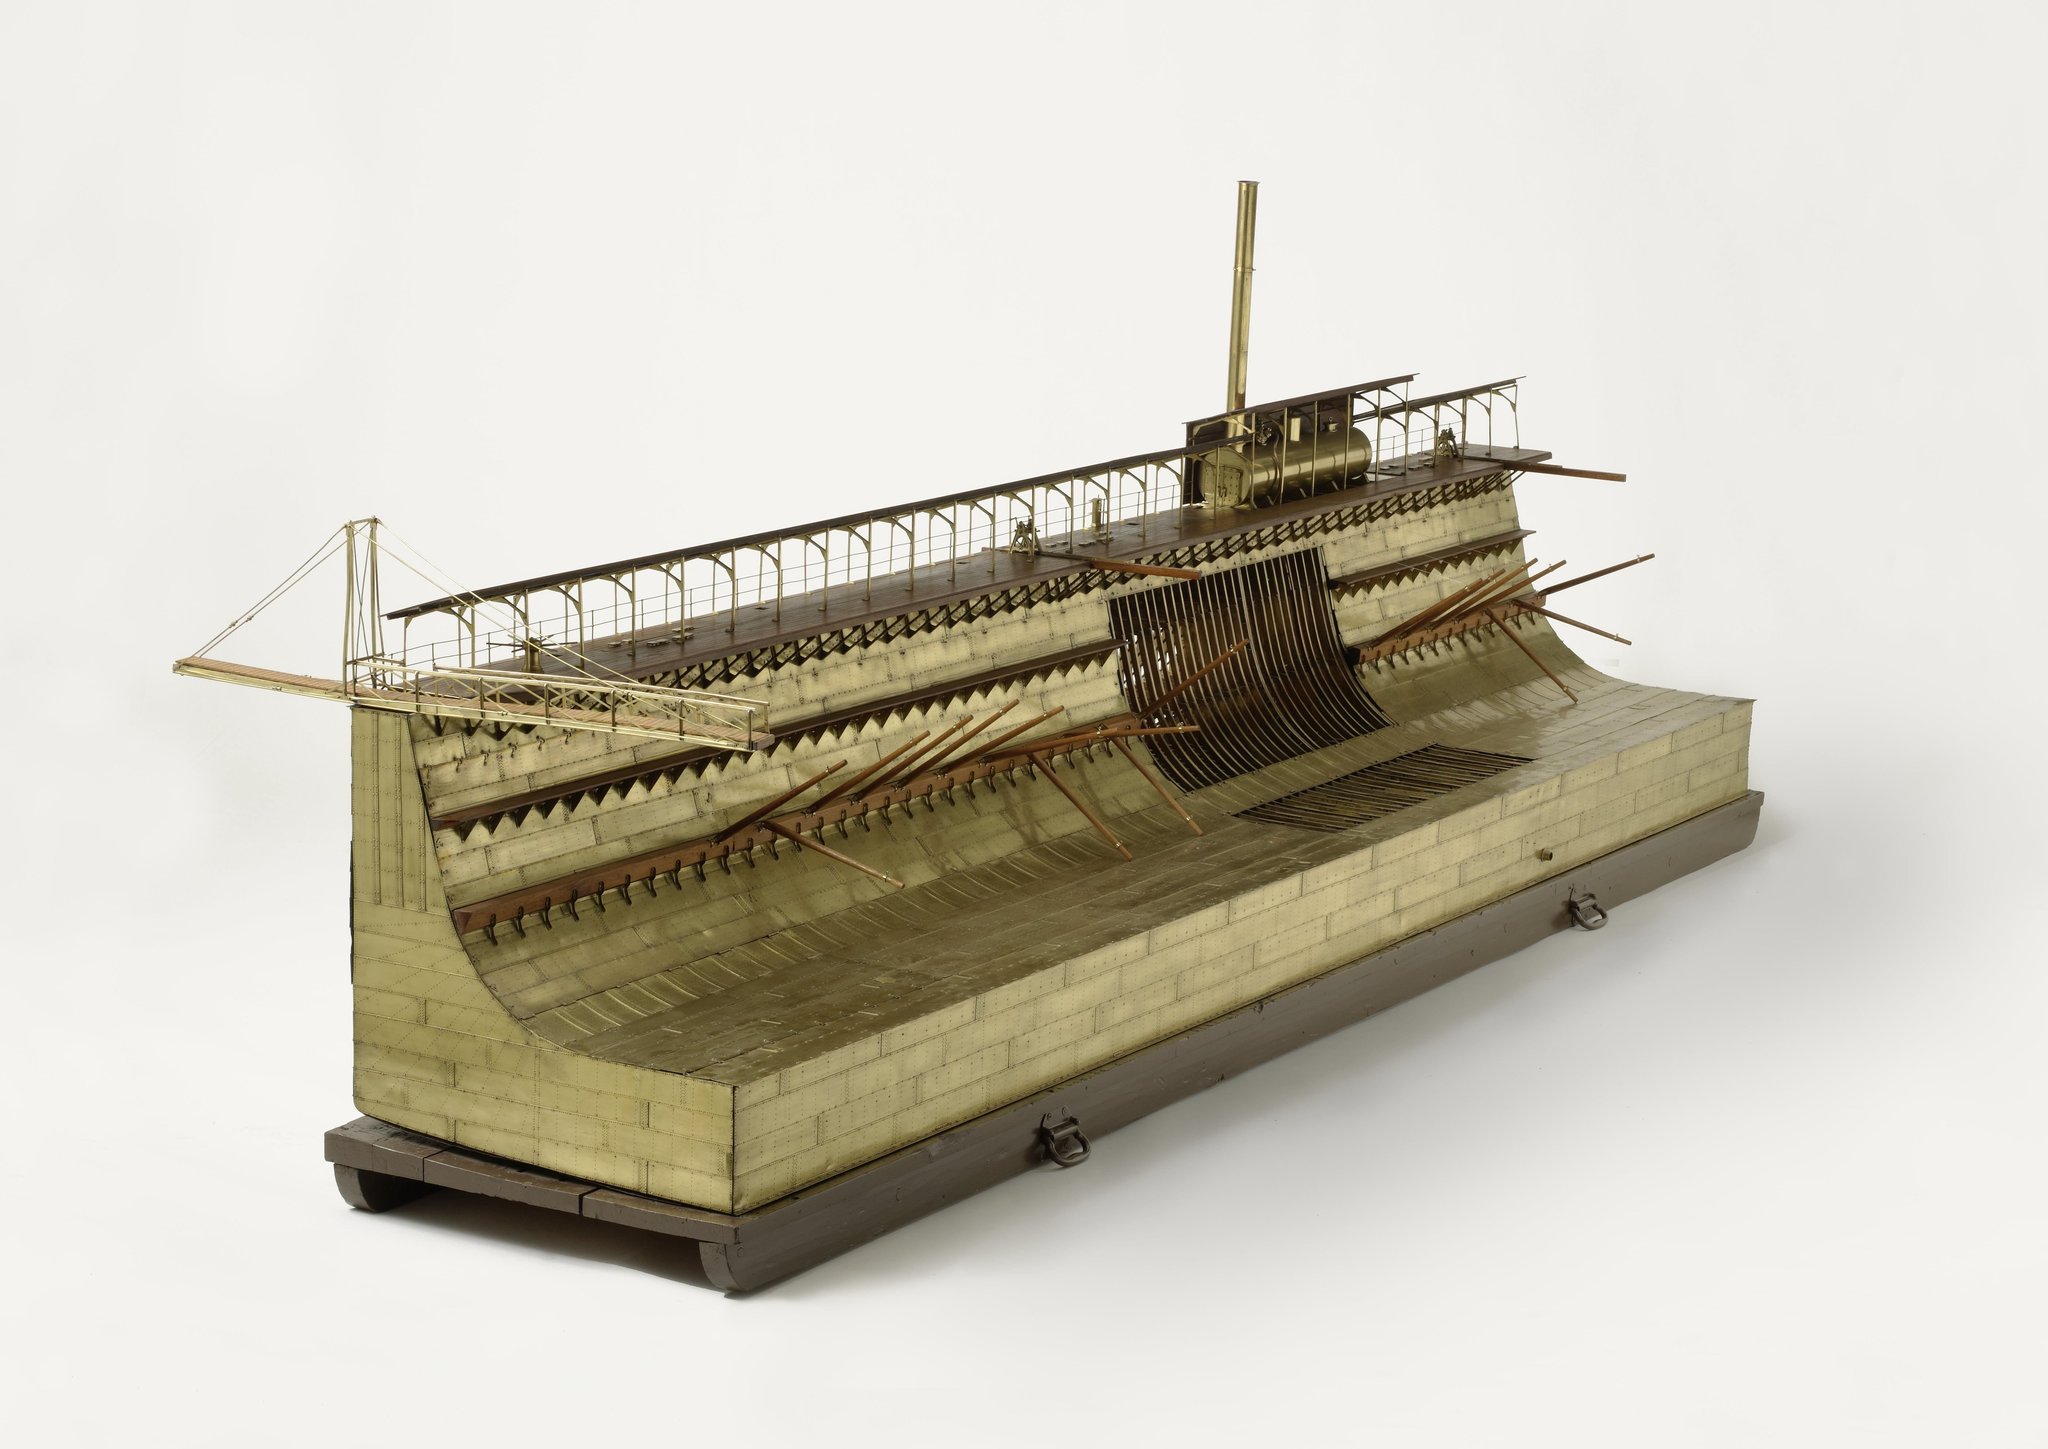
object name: scale model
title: Model of Part of a Floating Dry Dock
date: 1877-1878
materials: brass, paper, wood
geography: amsterdam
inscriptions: inscription, on a brass plaque: ‘Model op 1/20 van een gedeelte van het / YZEREN DRYVEND DOK / VOOR DE DIENST DER MARINE OP ONRUST IN OOST INDIE / Vervaardigd door de Koninklijke fabriek van / Stoom en andere Werktuigen / Amsterdam / 1878’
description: Het ijzeren drijvende droogdok, waarnaar dit model gemaakt is, werd in 1876 door de Koninklijke Fabriek voor Stoom- en andere Werktuigen van J. van der Made in Amsterdam op last van de Nederlandse regering gemaakt. Het was 100 m lang en had een draagvermogen van 4800 ton. In 1879 werd het uiteengenomen en verscheept naar Soerabaya, waar het weer in elkaar gezet werd en naar het eiland Onrust gesleept om daar het oude droogdok te vervangen (zie NG-MC-1187). Het model is in 1878 tentoongesteld op de Wereldtentoonstelling te Parijs.